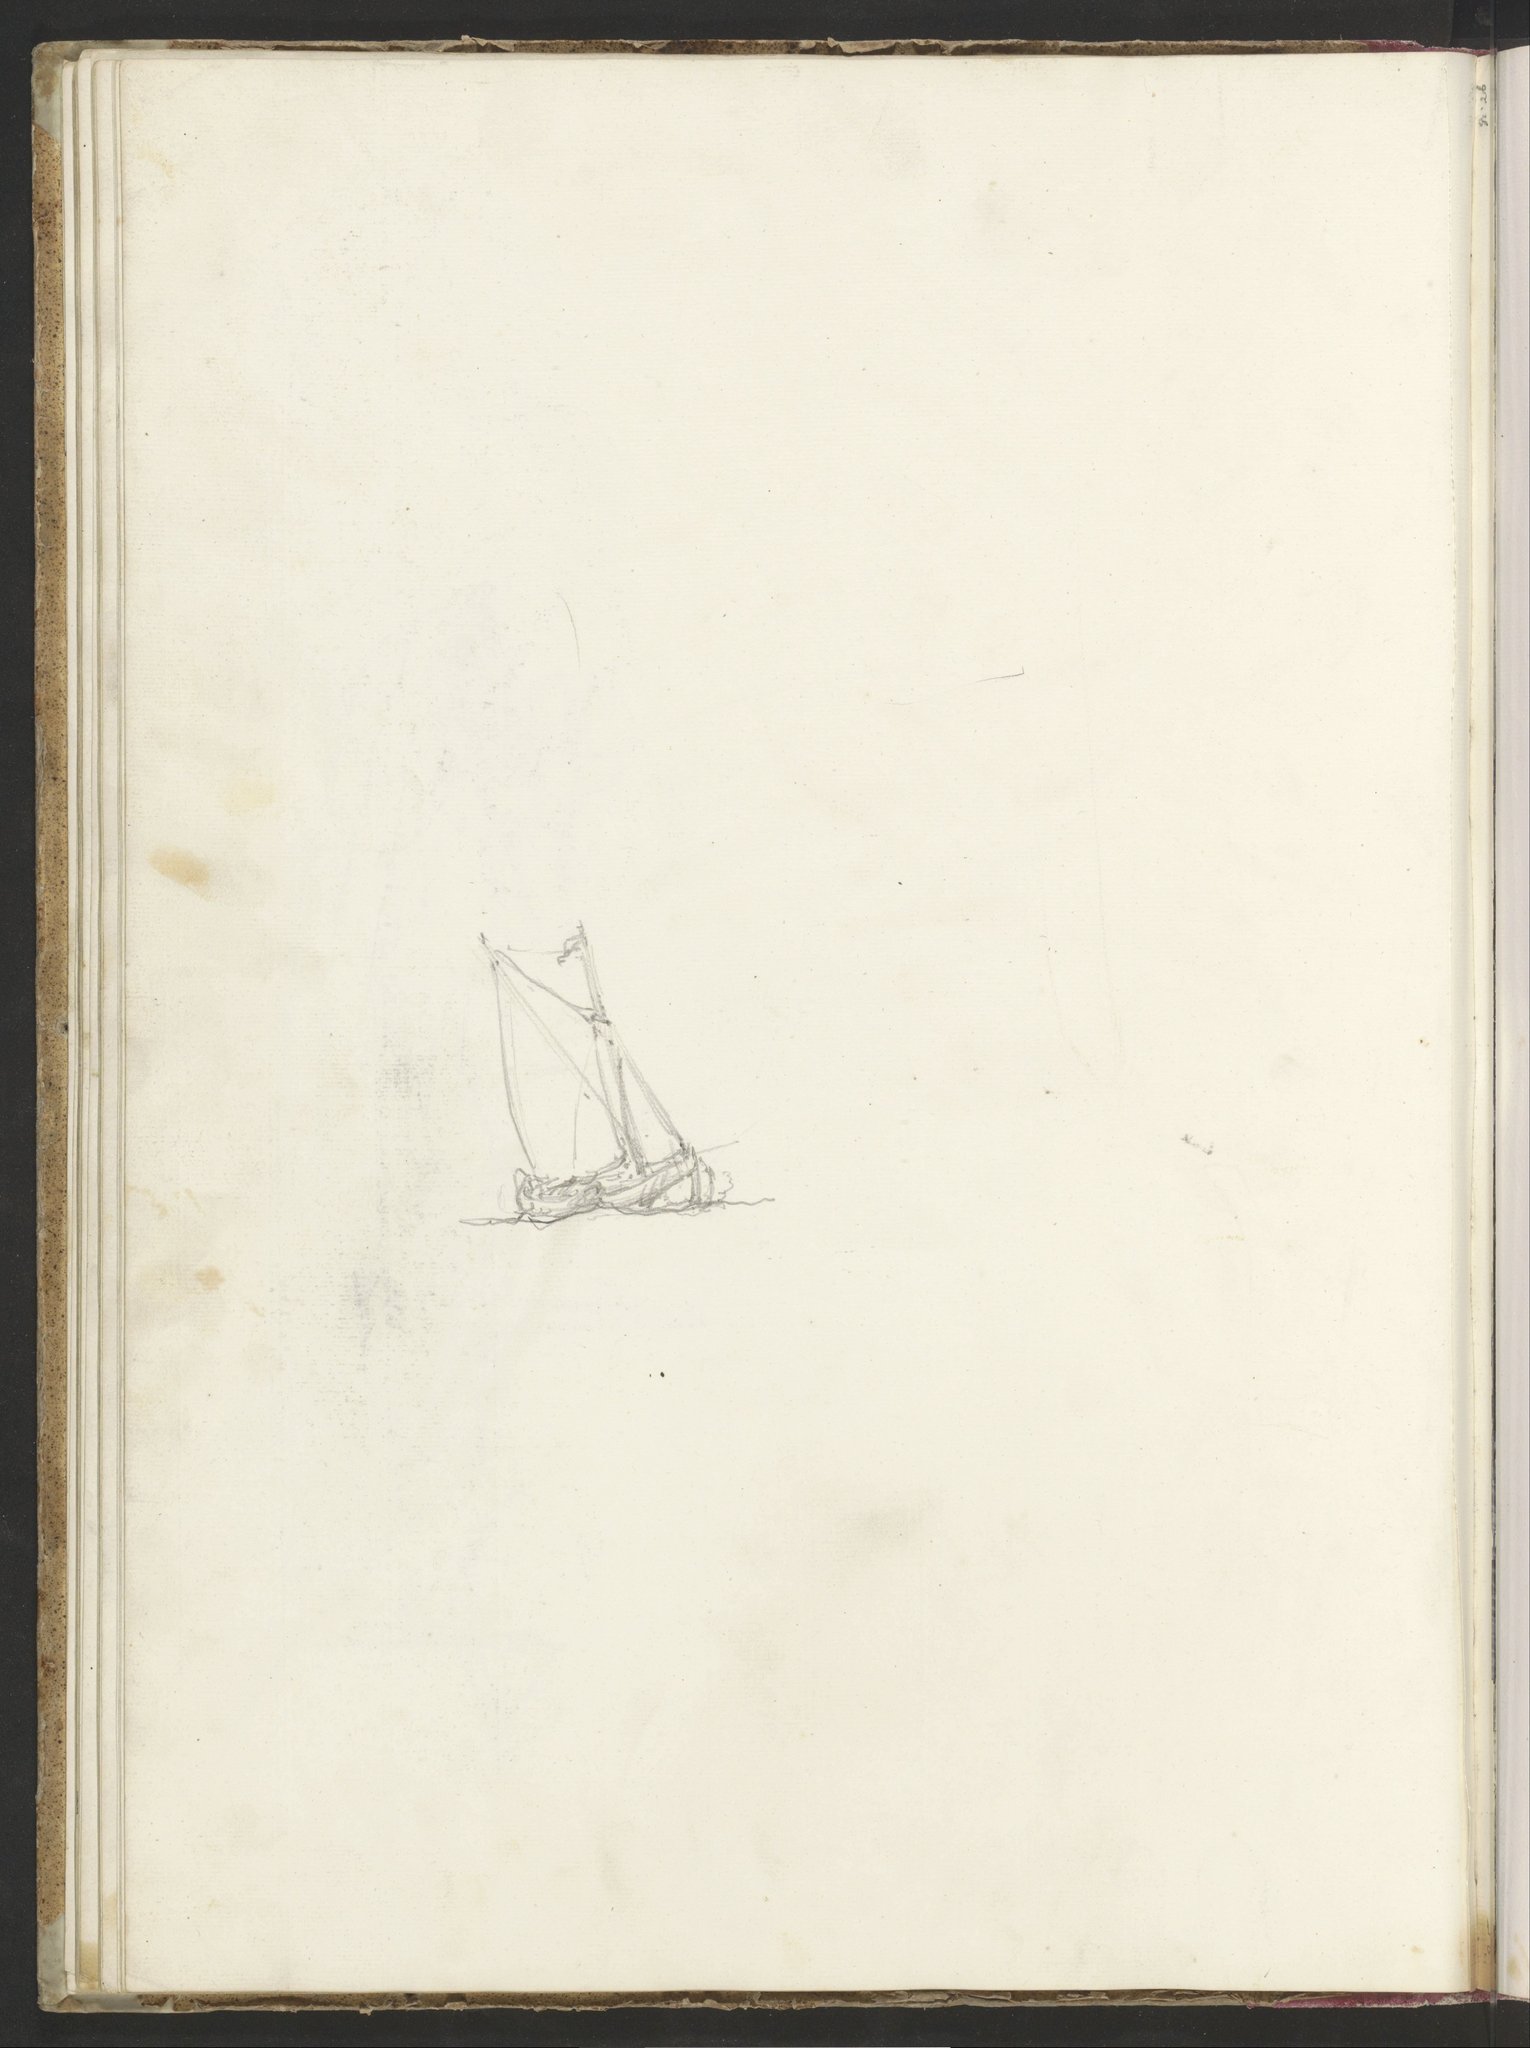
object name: sketchbook leaf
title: Zeilboot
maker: johannes christiaan schotel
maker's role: draughtsman, painter, print maker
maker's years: 1787-1838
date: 1797-1838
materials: paper, pencil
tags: sailing-ship, sailing-boat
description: Blad 24 verso uit een schetsboek met 65 bladen.